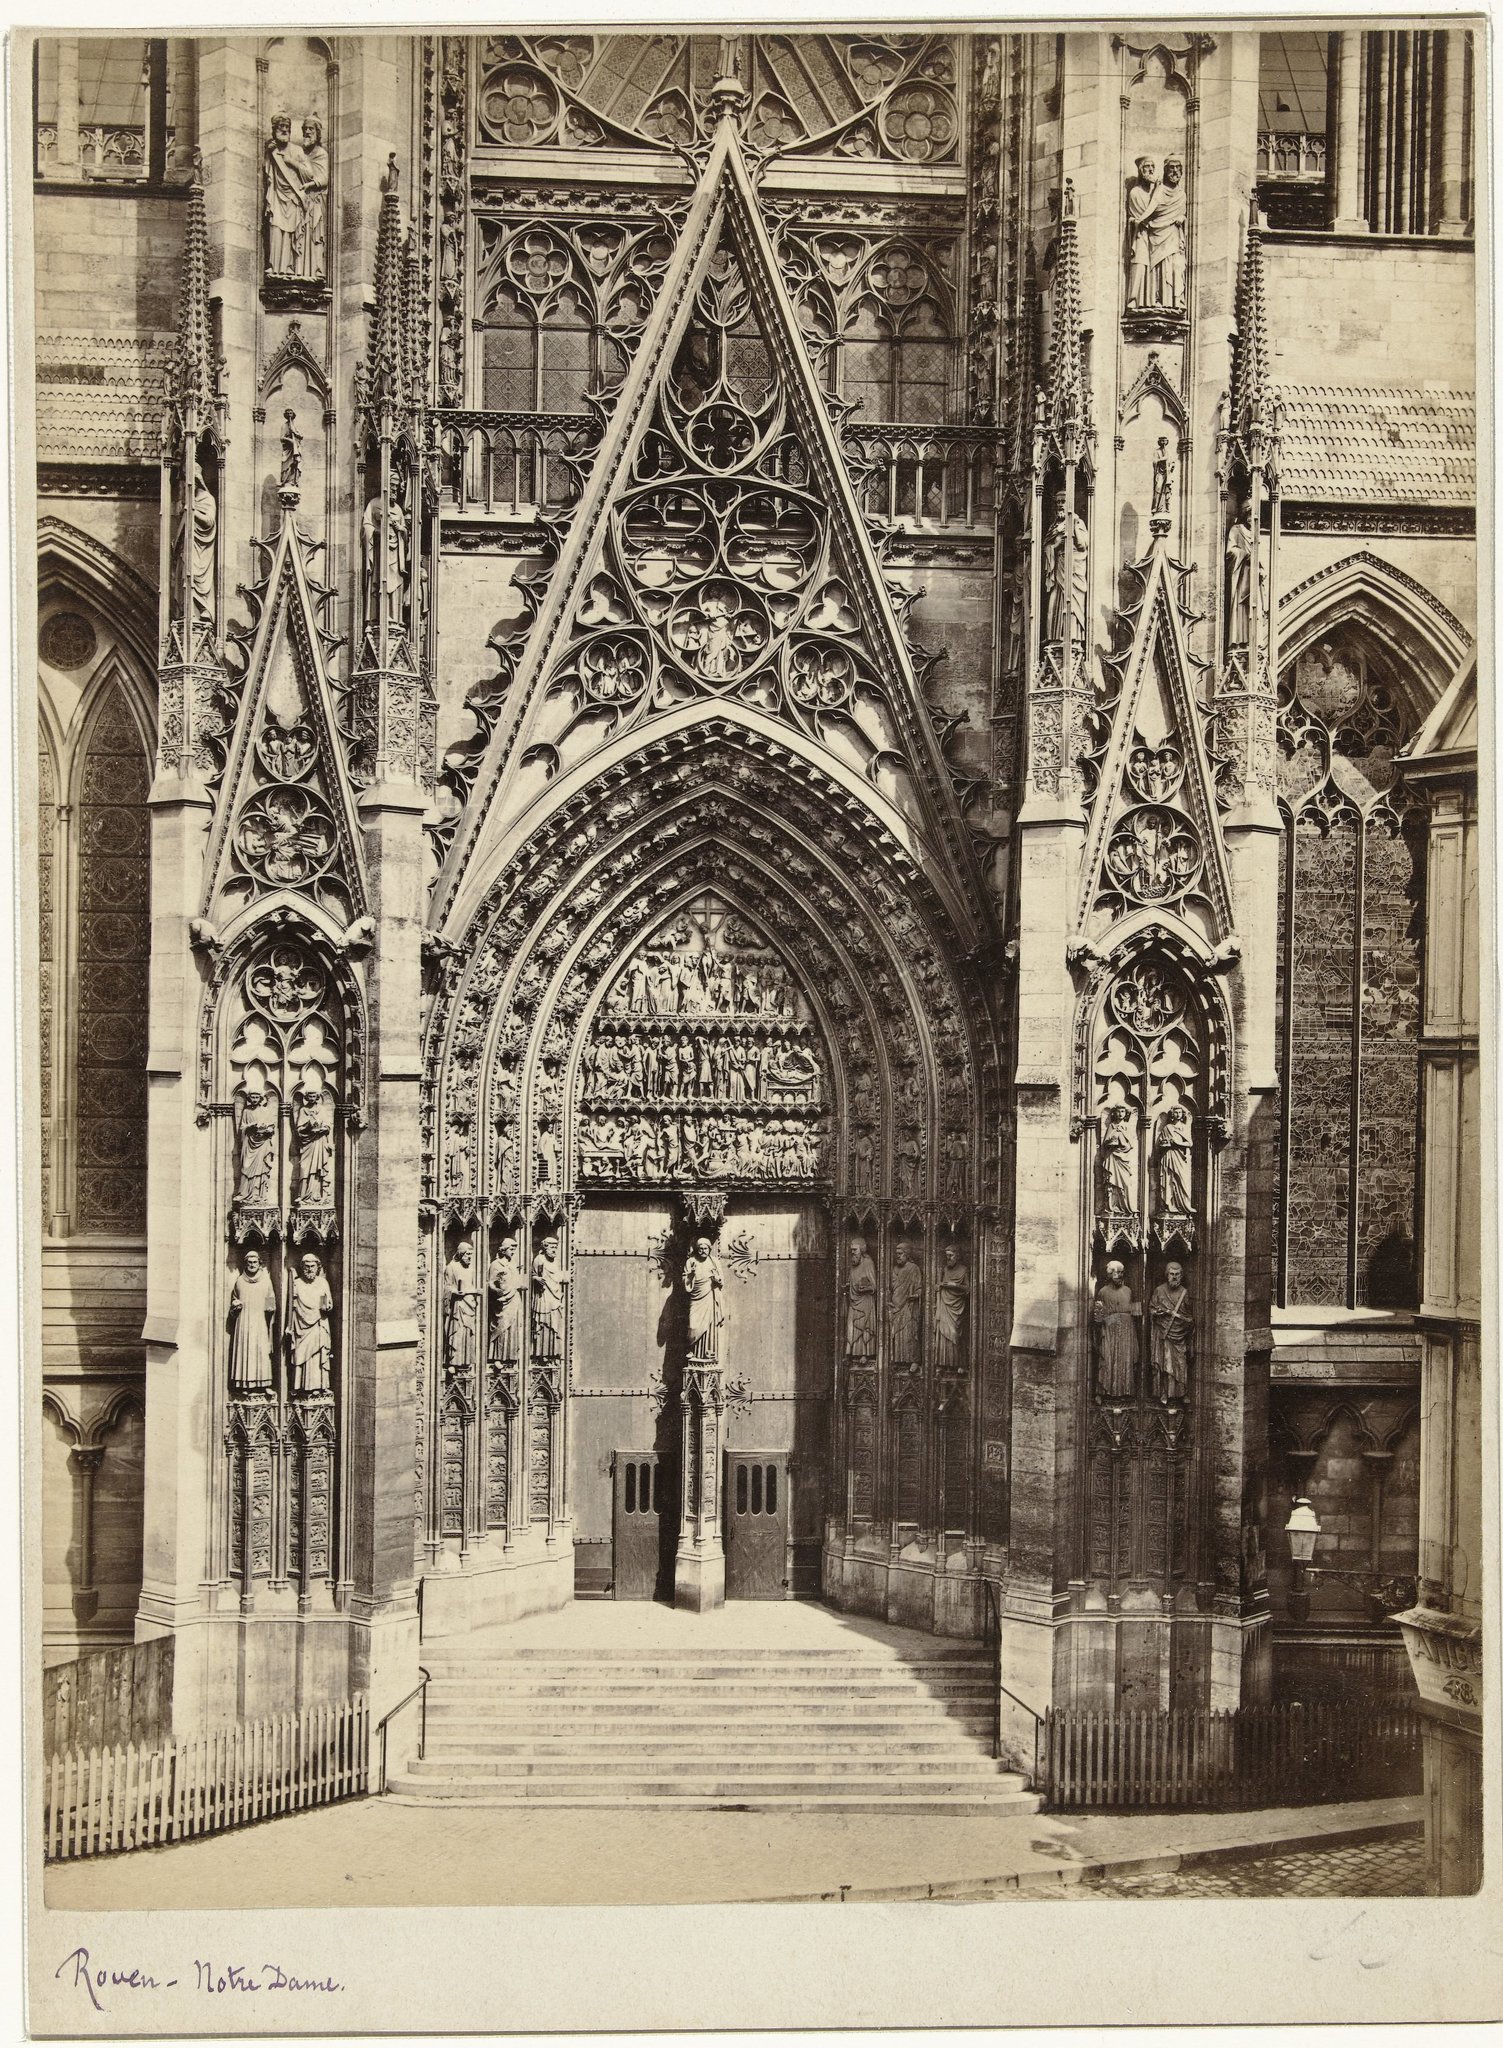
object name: photograph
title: Façade van de Kathedraal van Rouen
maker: Anonymous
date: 1860-1900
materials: cardboard, paper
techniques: albumen print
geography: rouen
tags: church (exterior)